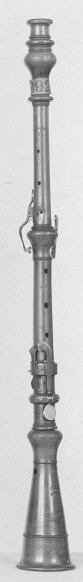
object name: oboe in c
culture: german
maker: h. c. tölcke (heinrich carl)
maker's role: maker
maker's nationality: german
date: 1792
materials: wood, brass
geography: germany